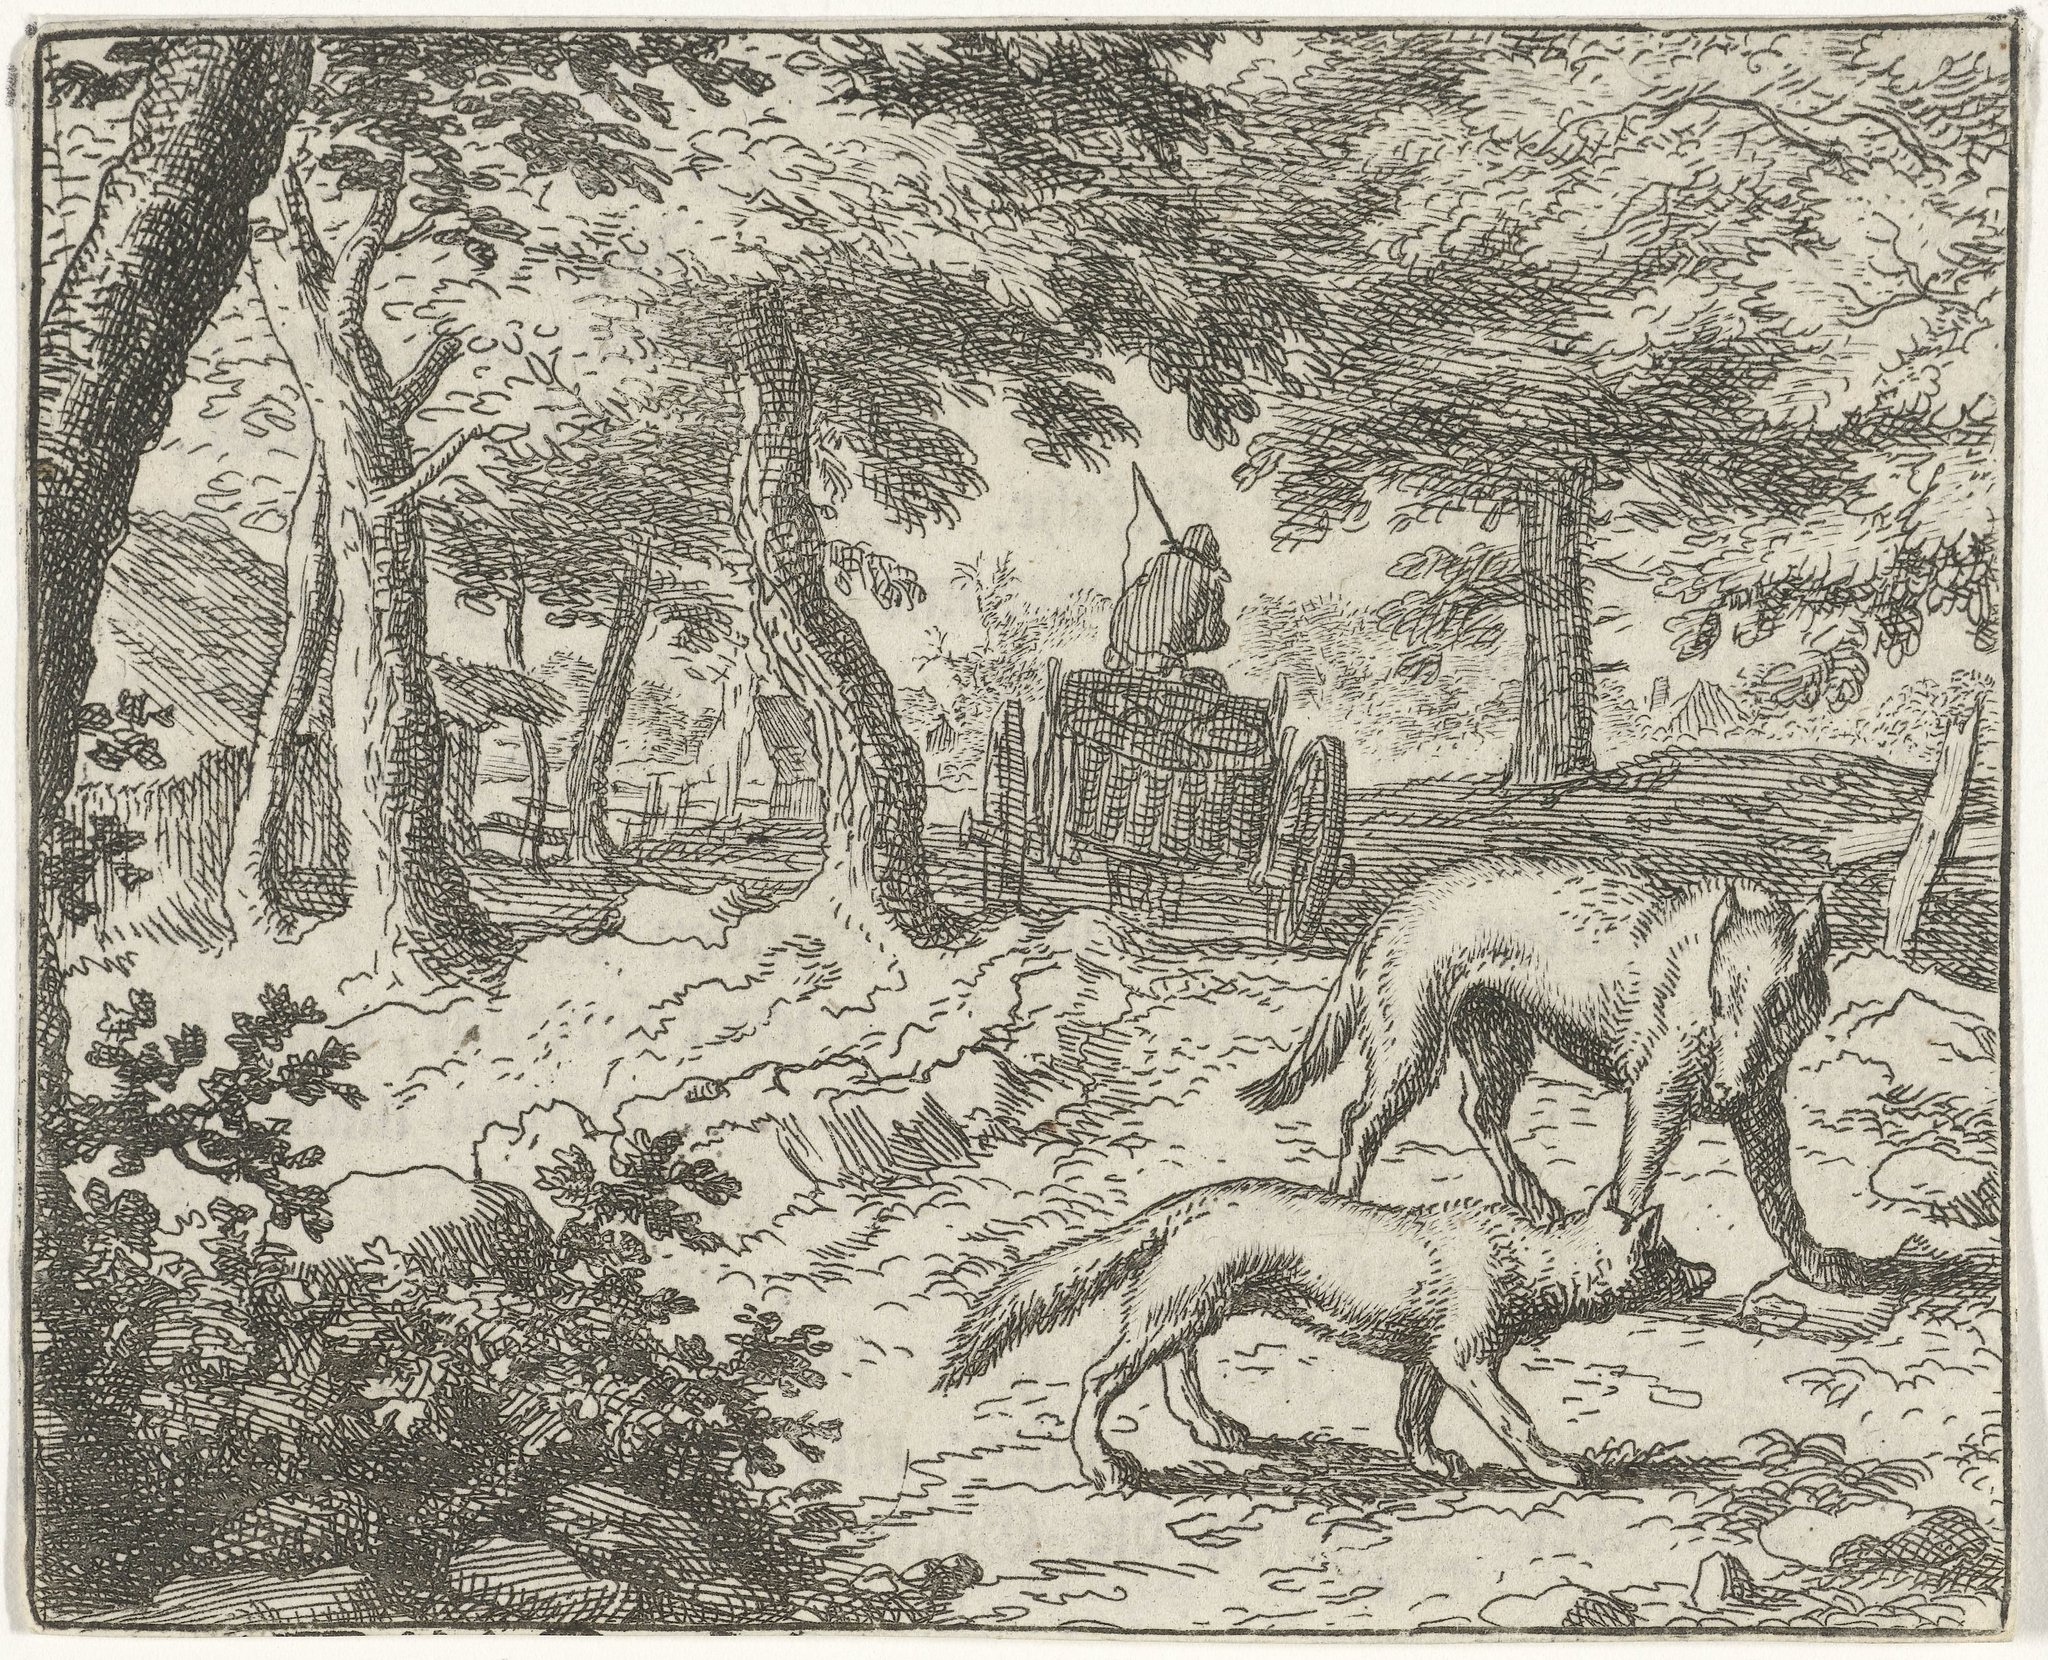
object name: book illustration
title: Illustraties voor Reijntje de Vos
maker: allaert van everdingen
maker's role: draughtsman, painter, print maker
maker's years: 1621-1675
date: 1665-1675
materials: paper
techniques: etching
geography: netherlands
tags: fable of reynard the fox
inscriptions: collector's mark: Lugt 2228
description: Grimbeert de das en Reinaert de vos tegenover elkaar in een bos. Op de achtergrond een man op een kar. Op de achterkant van de prent een Duits tekstfragment uit het verhaal van Reinaert de vos.